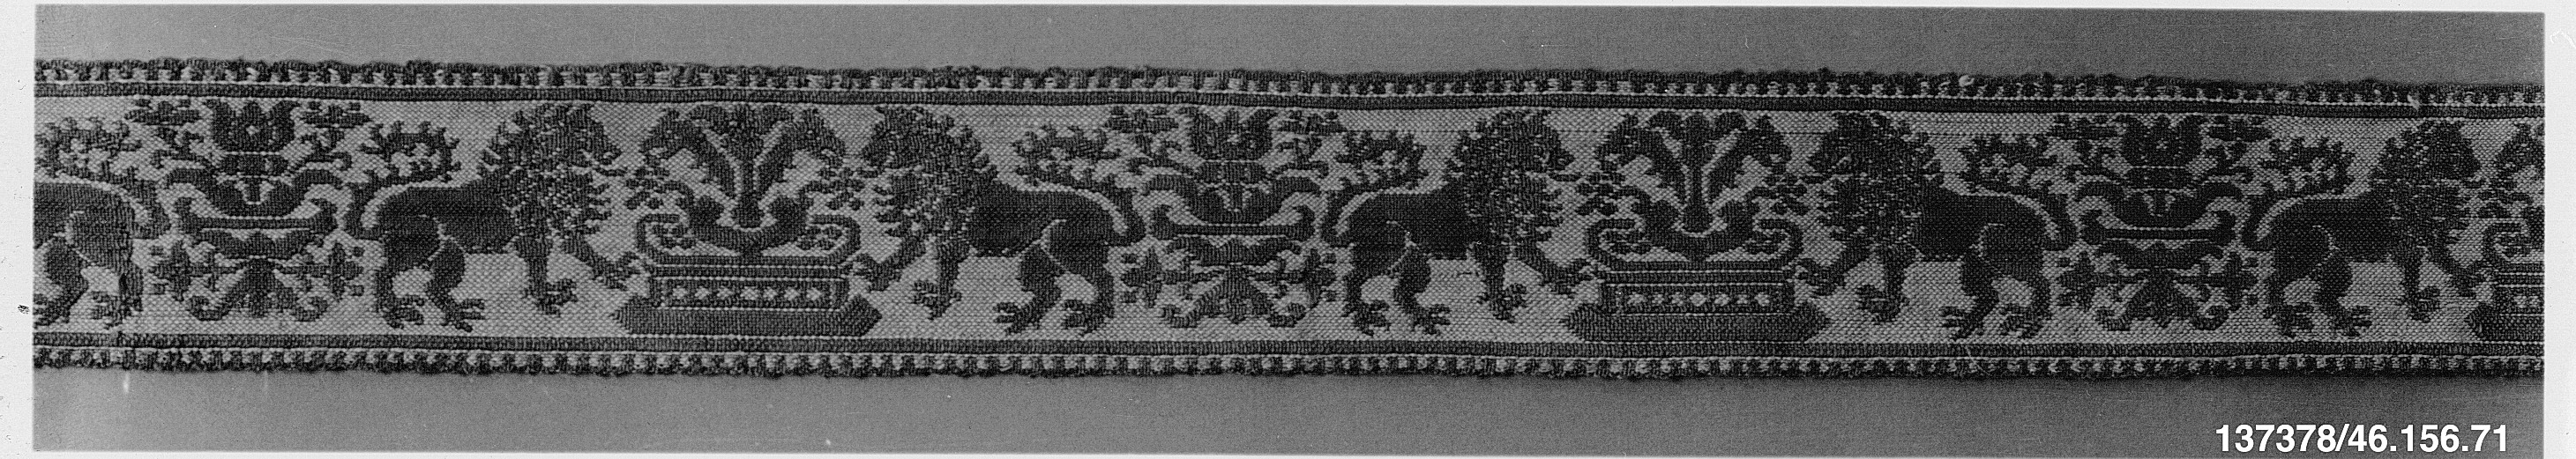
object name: band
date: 1501-1600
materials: linen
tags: animals